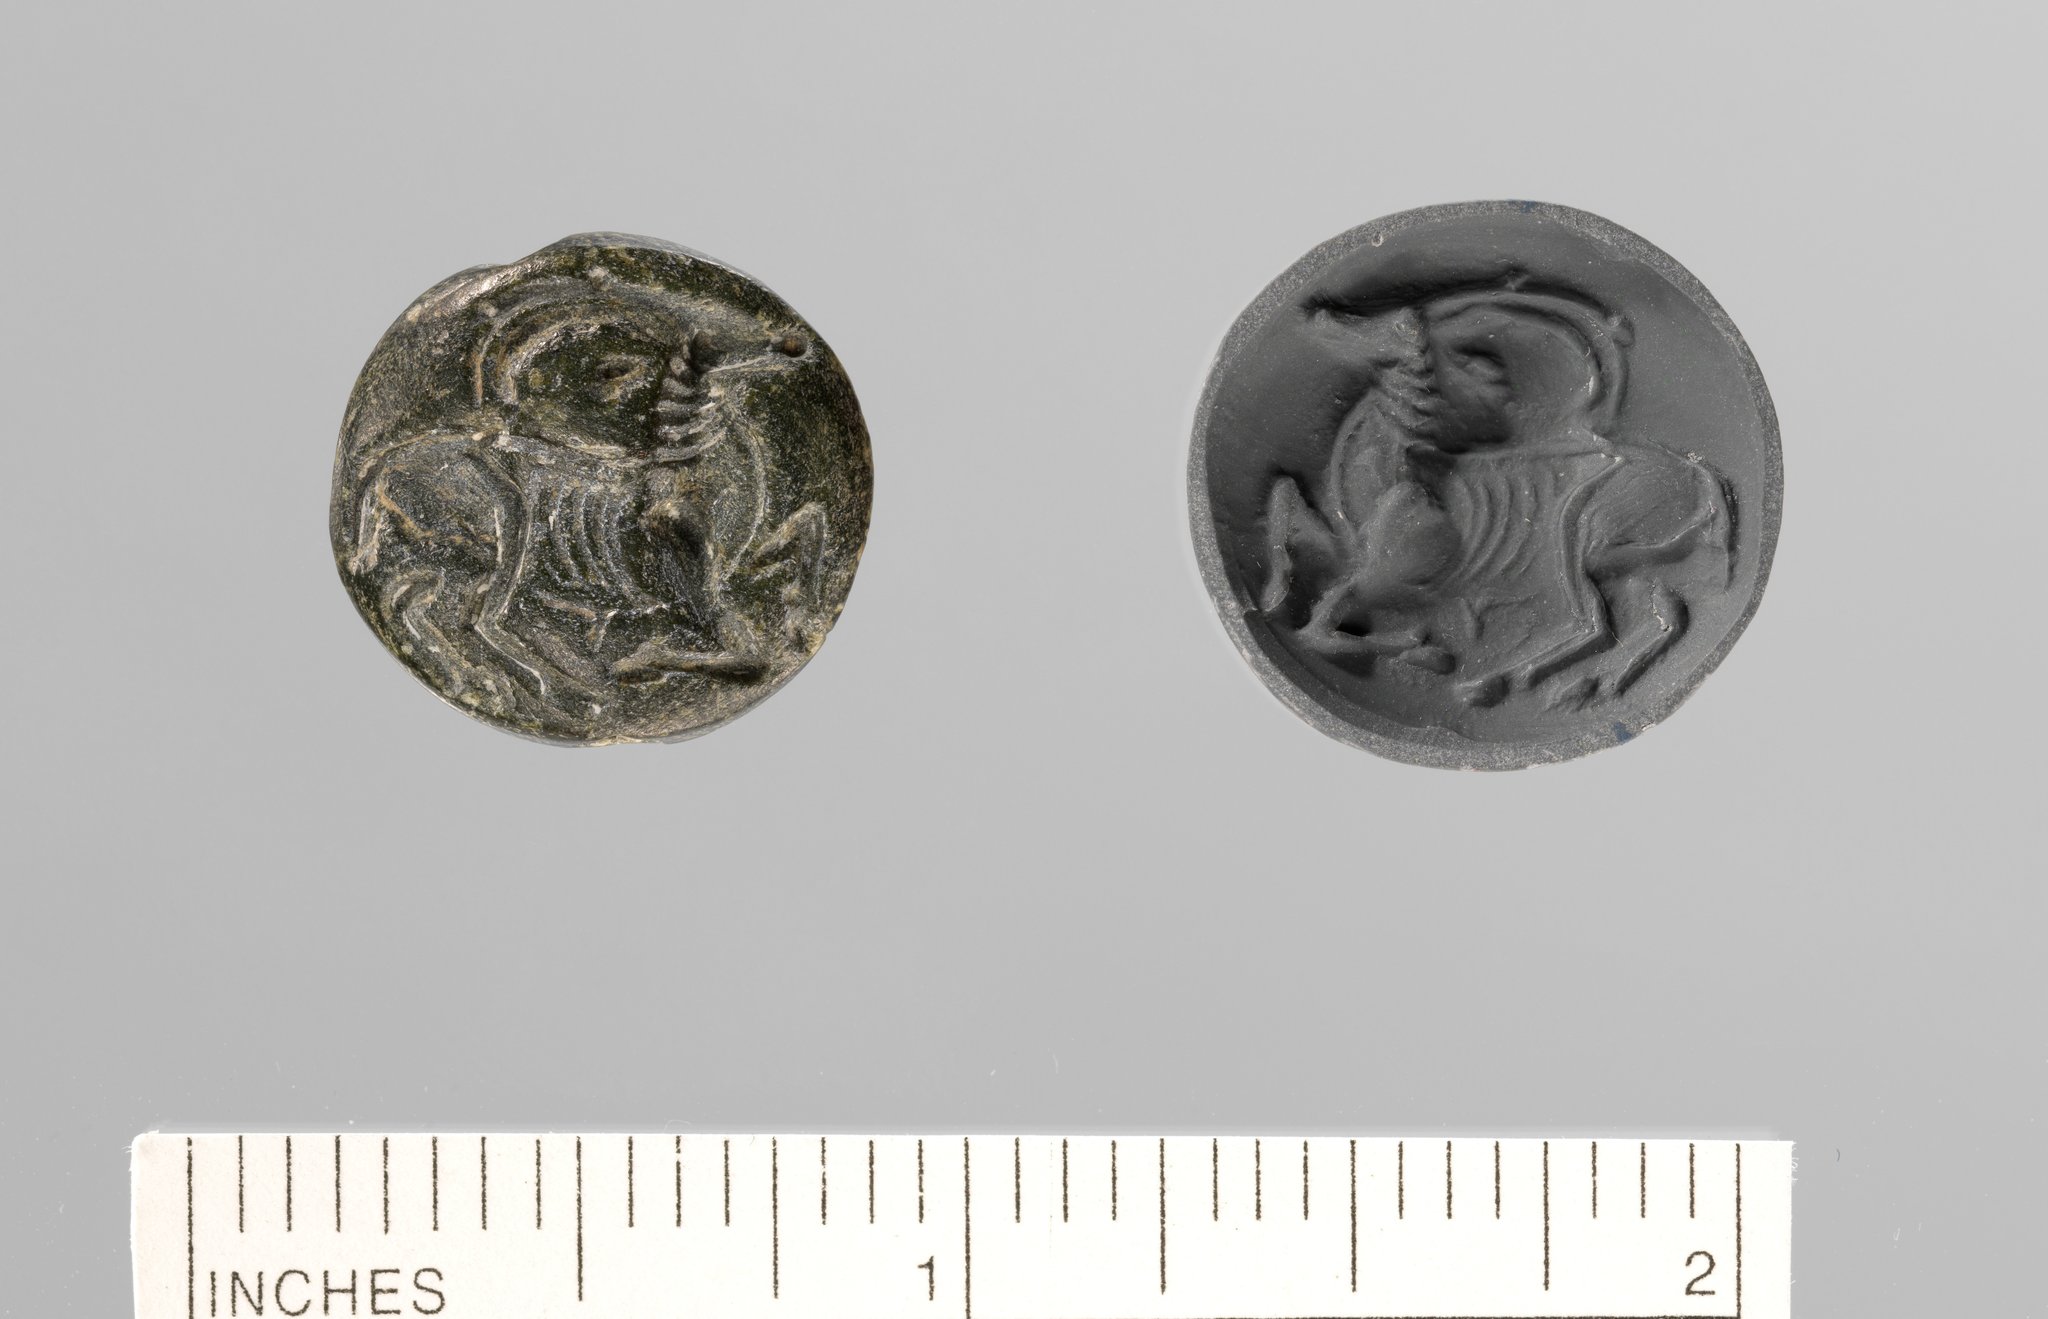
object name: seal, lentoid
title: Serpentine Lentoid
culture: minoan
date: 1400-1375 BCE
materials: stone